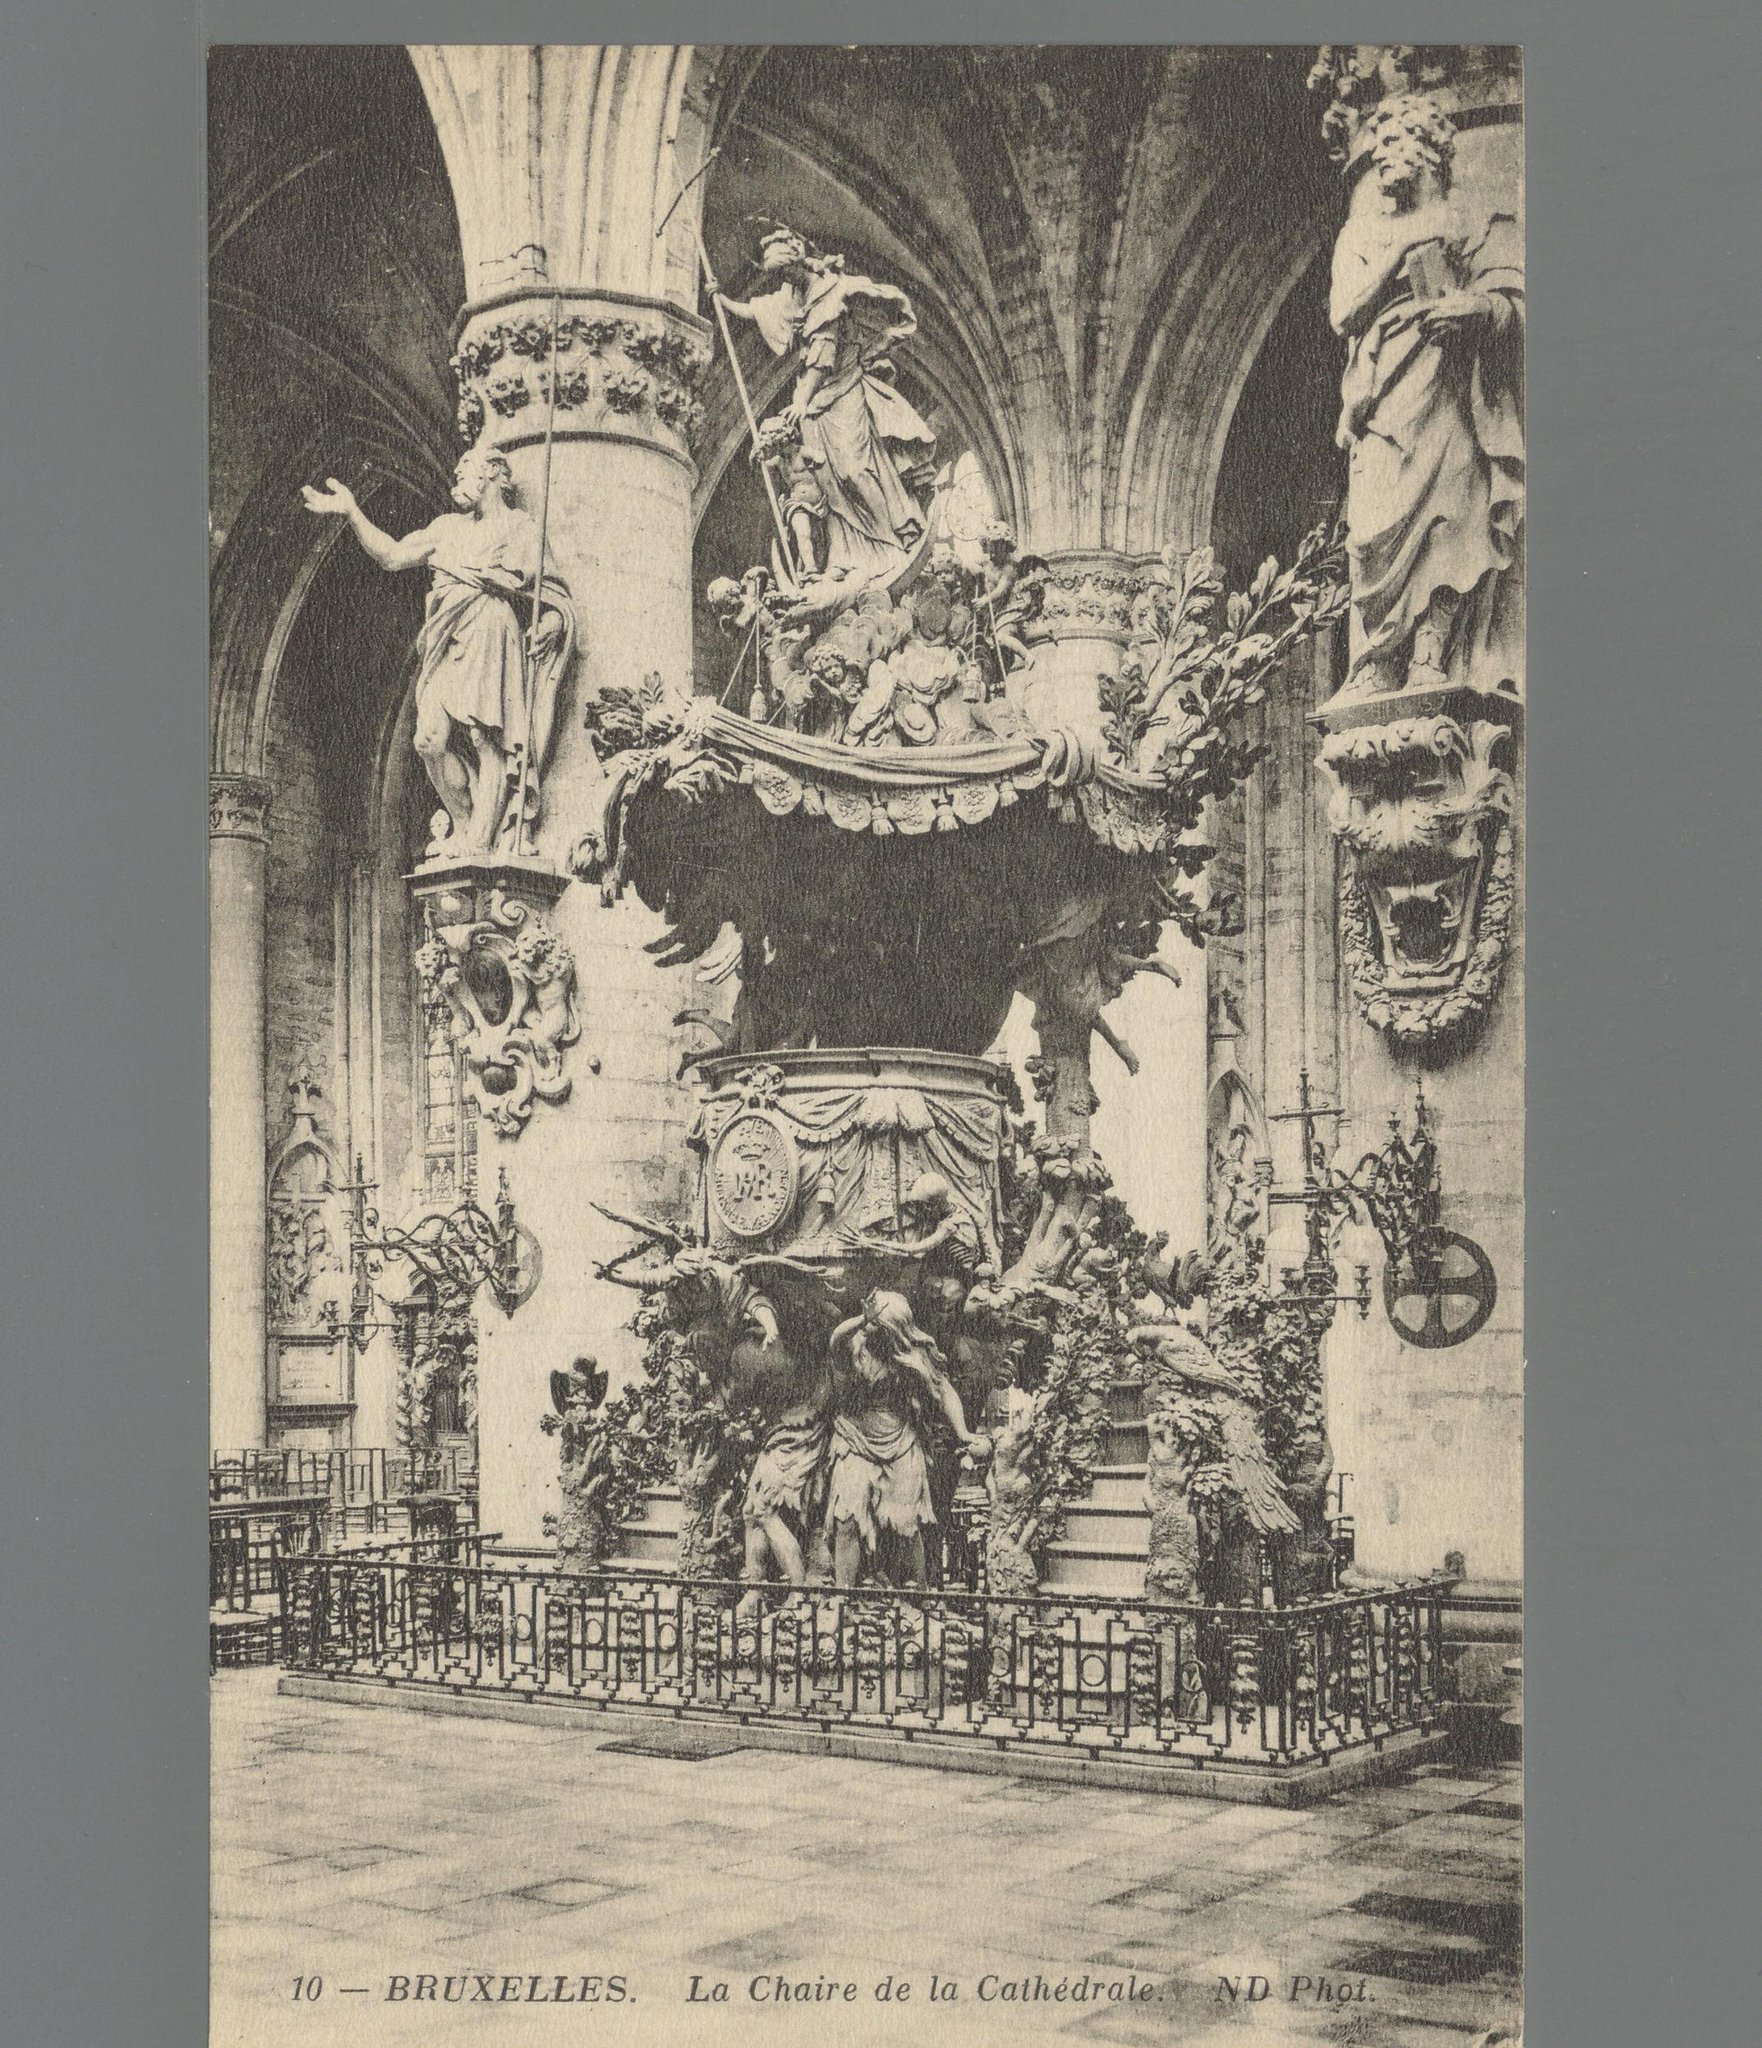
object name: photomechanical print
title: Bruxelles. La chaire de la cathédrale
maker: Anonymous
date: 1906-1918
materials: cardboard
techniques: photograph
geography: brussels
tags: interior of church, pulpit, ambo, chancel